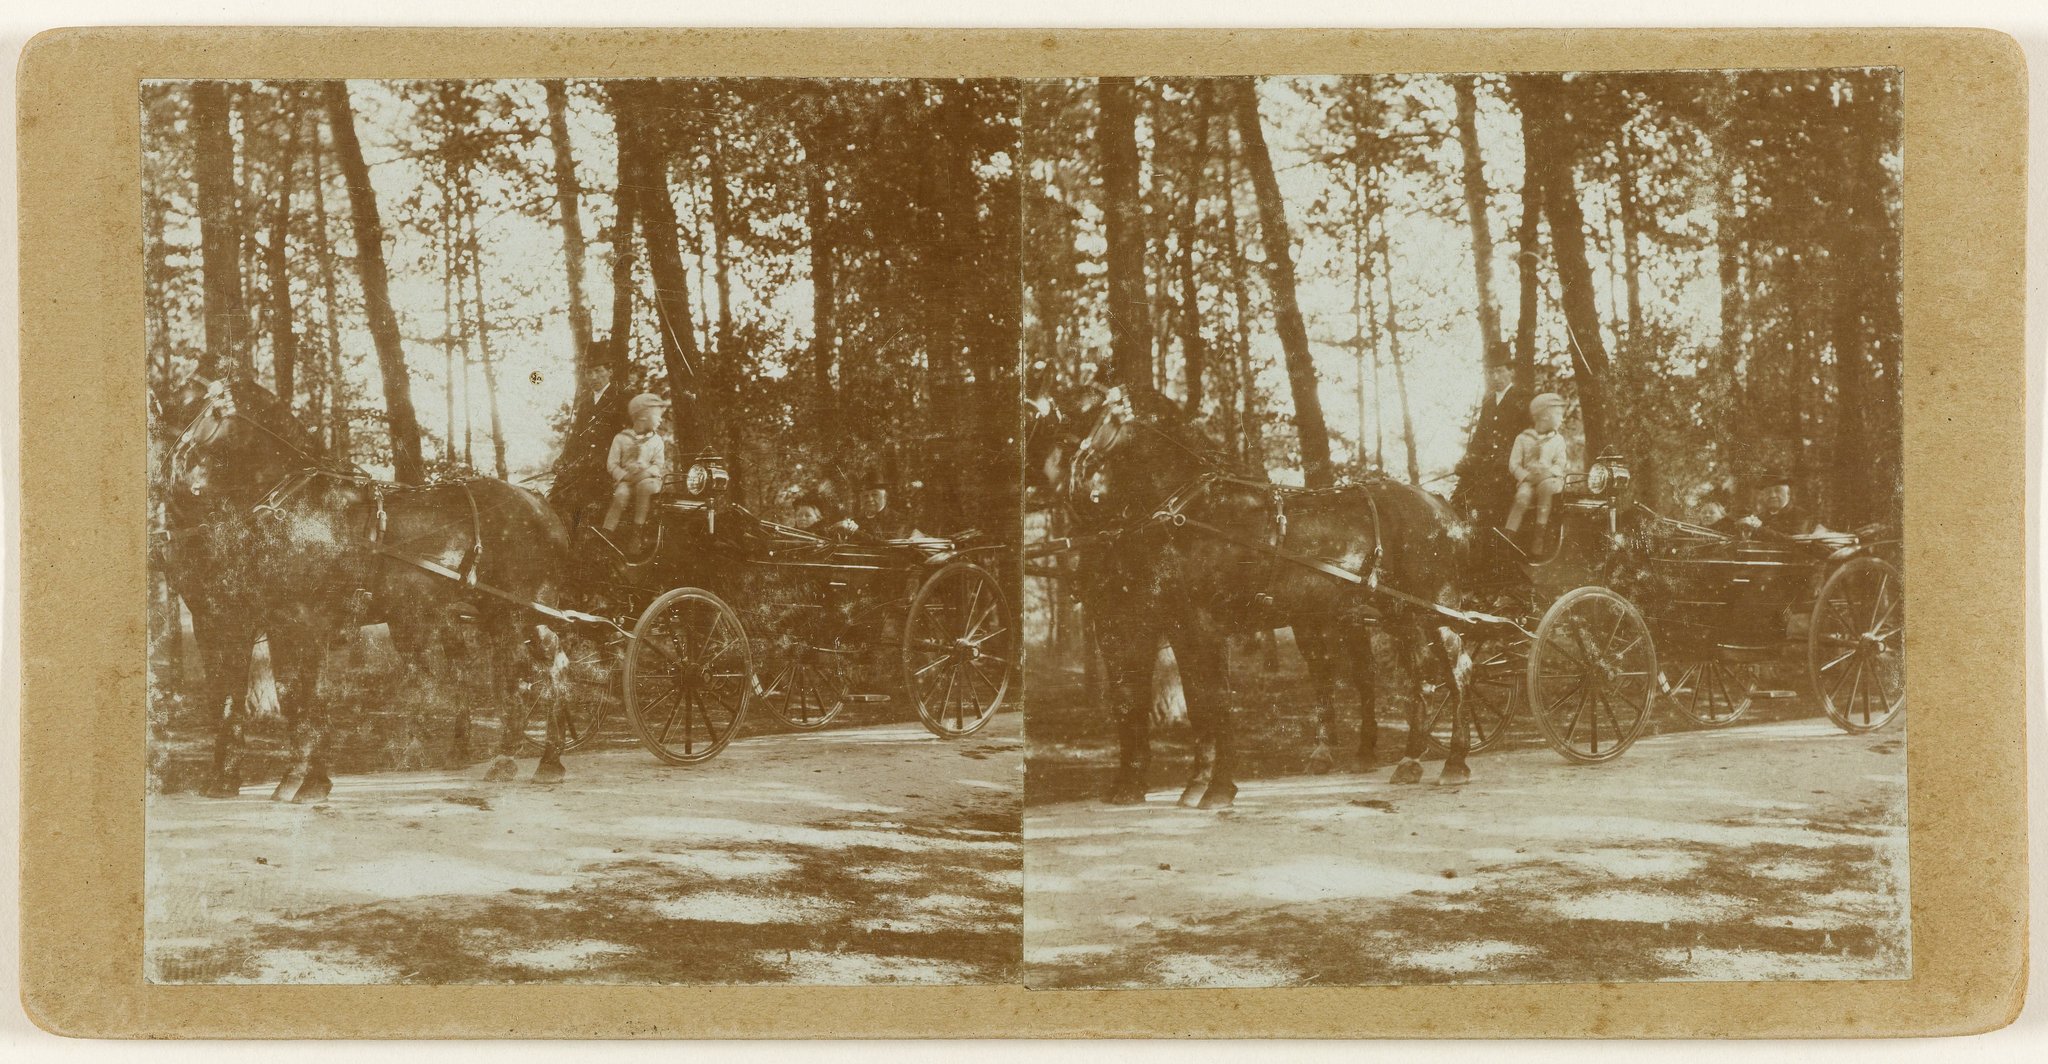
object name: stereograph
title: Het echtpaar Ten Cate in een rijtuig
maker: e. ten cate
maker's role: fotograaf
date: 1905-1910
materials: cardboard, photographic support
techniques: gelatin silver print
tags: four-wheeled vehicle drawn by two animals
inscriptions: annotation: ‘Pa en Ma ten Cate // in t rijtuig // Egbertje naast Willem op de bok // Mei 1910’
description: Een dame en een heer in een rijtuig. Een jongen die achterom kijkt, zit naast de koetsier op de bok.